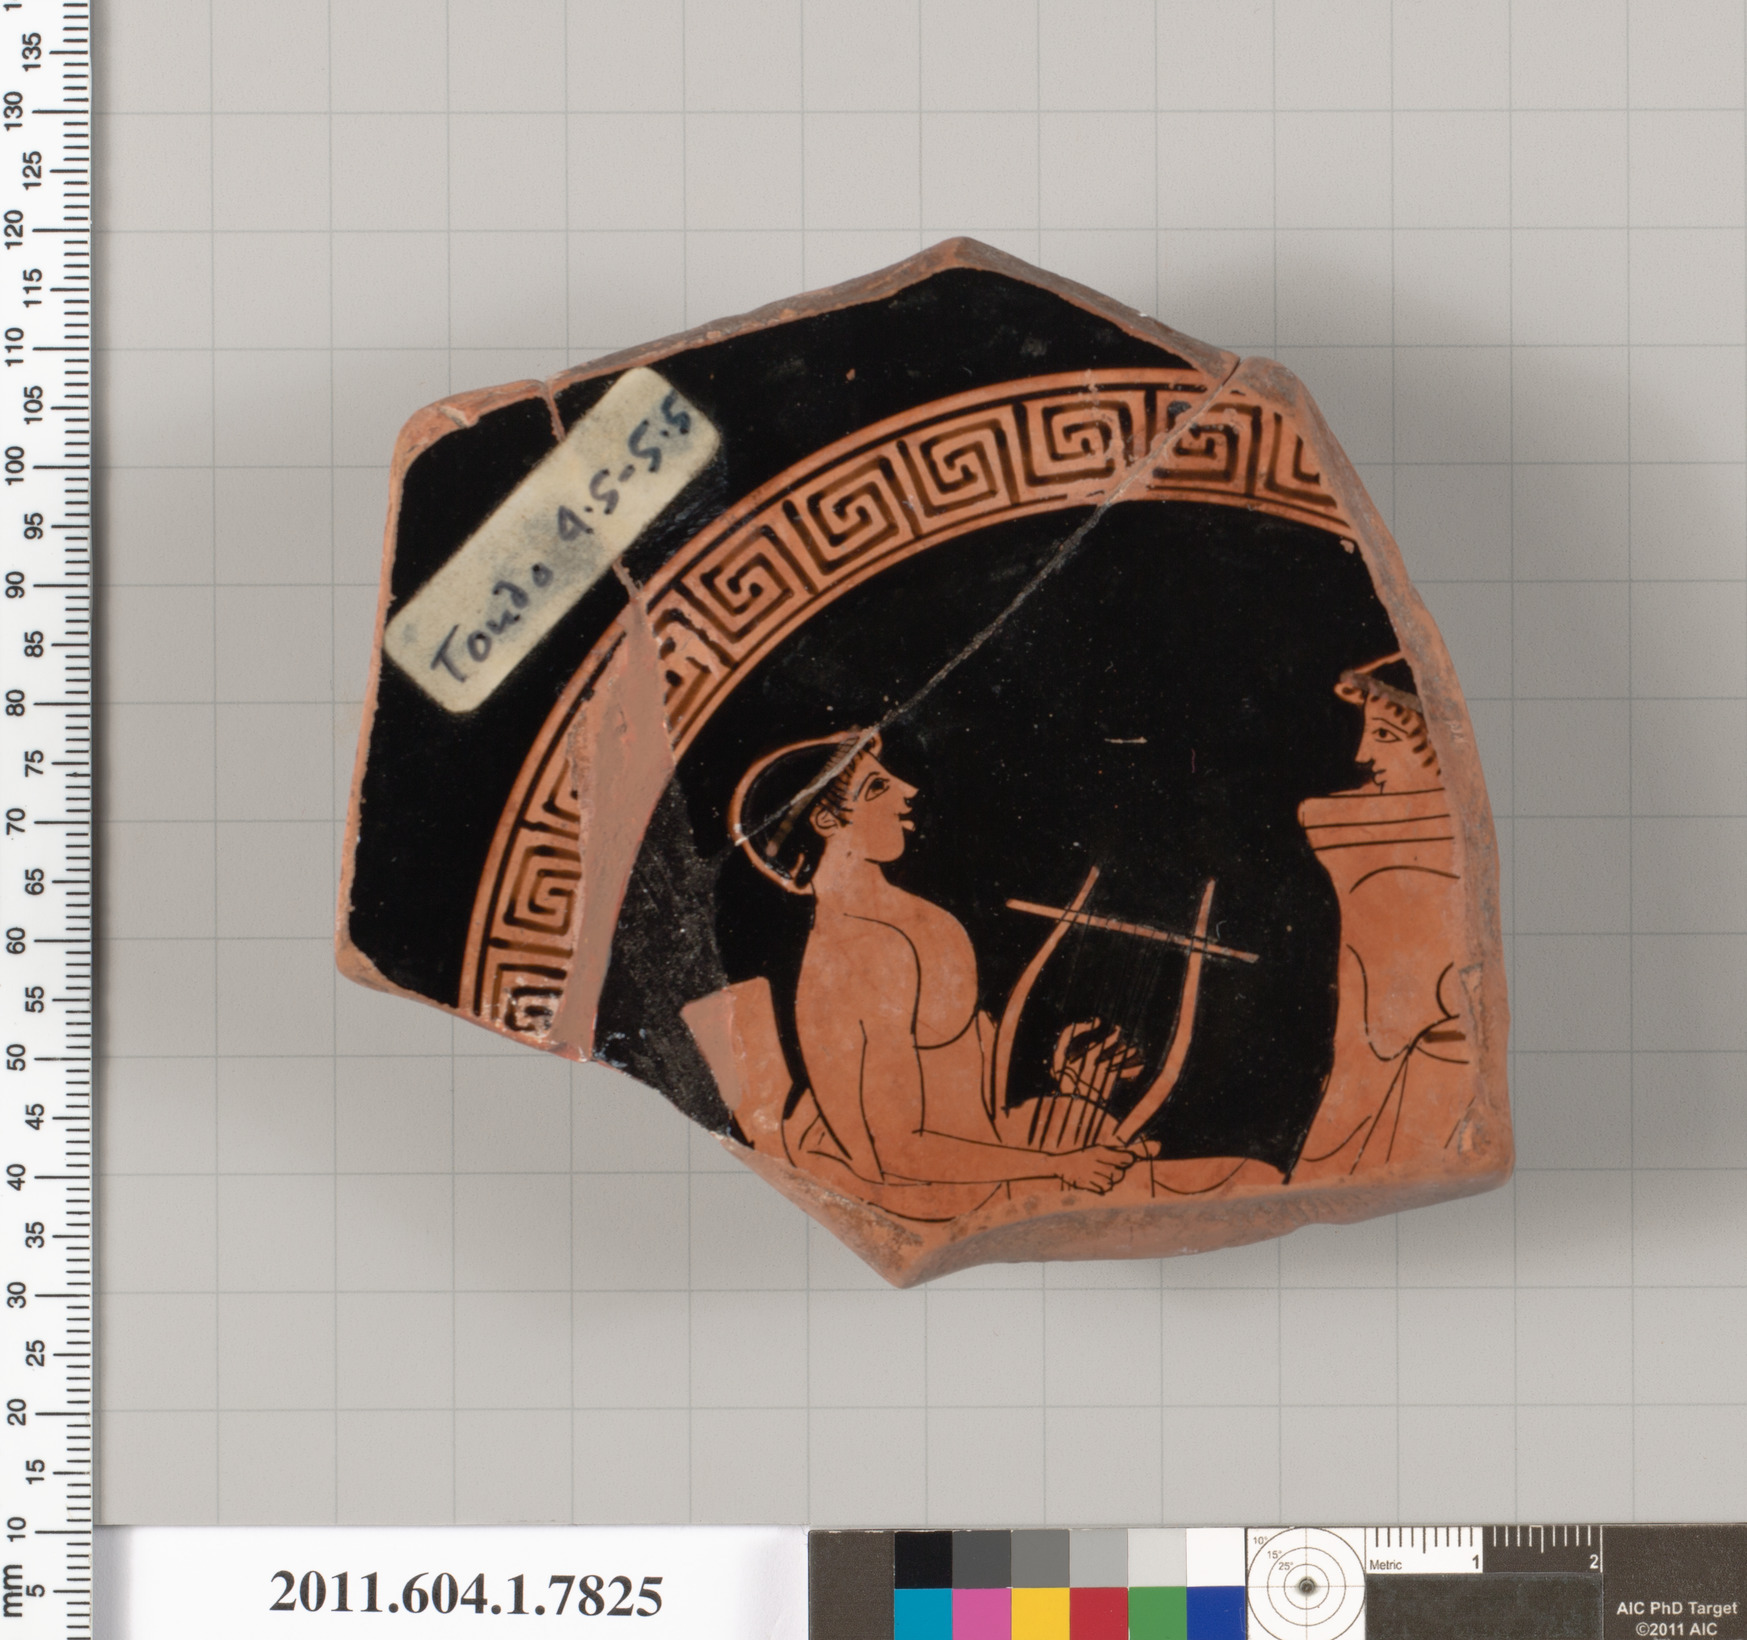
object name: kylix fragment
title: Terracotta fragment of a kylix (drinking cup)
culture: greek, attic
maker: sabouroff painter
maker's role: artist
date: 467-435 BCE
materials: terracotta